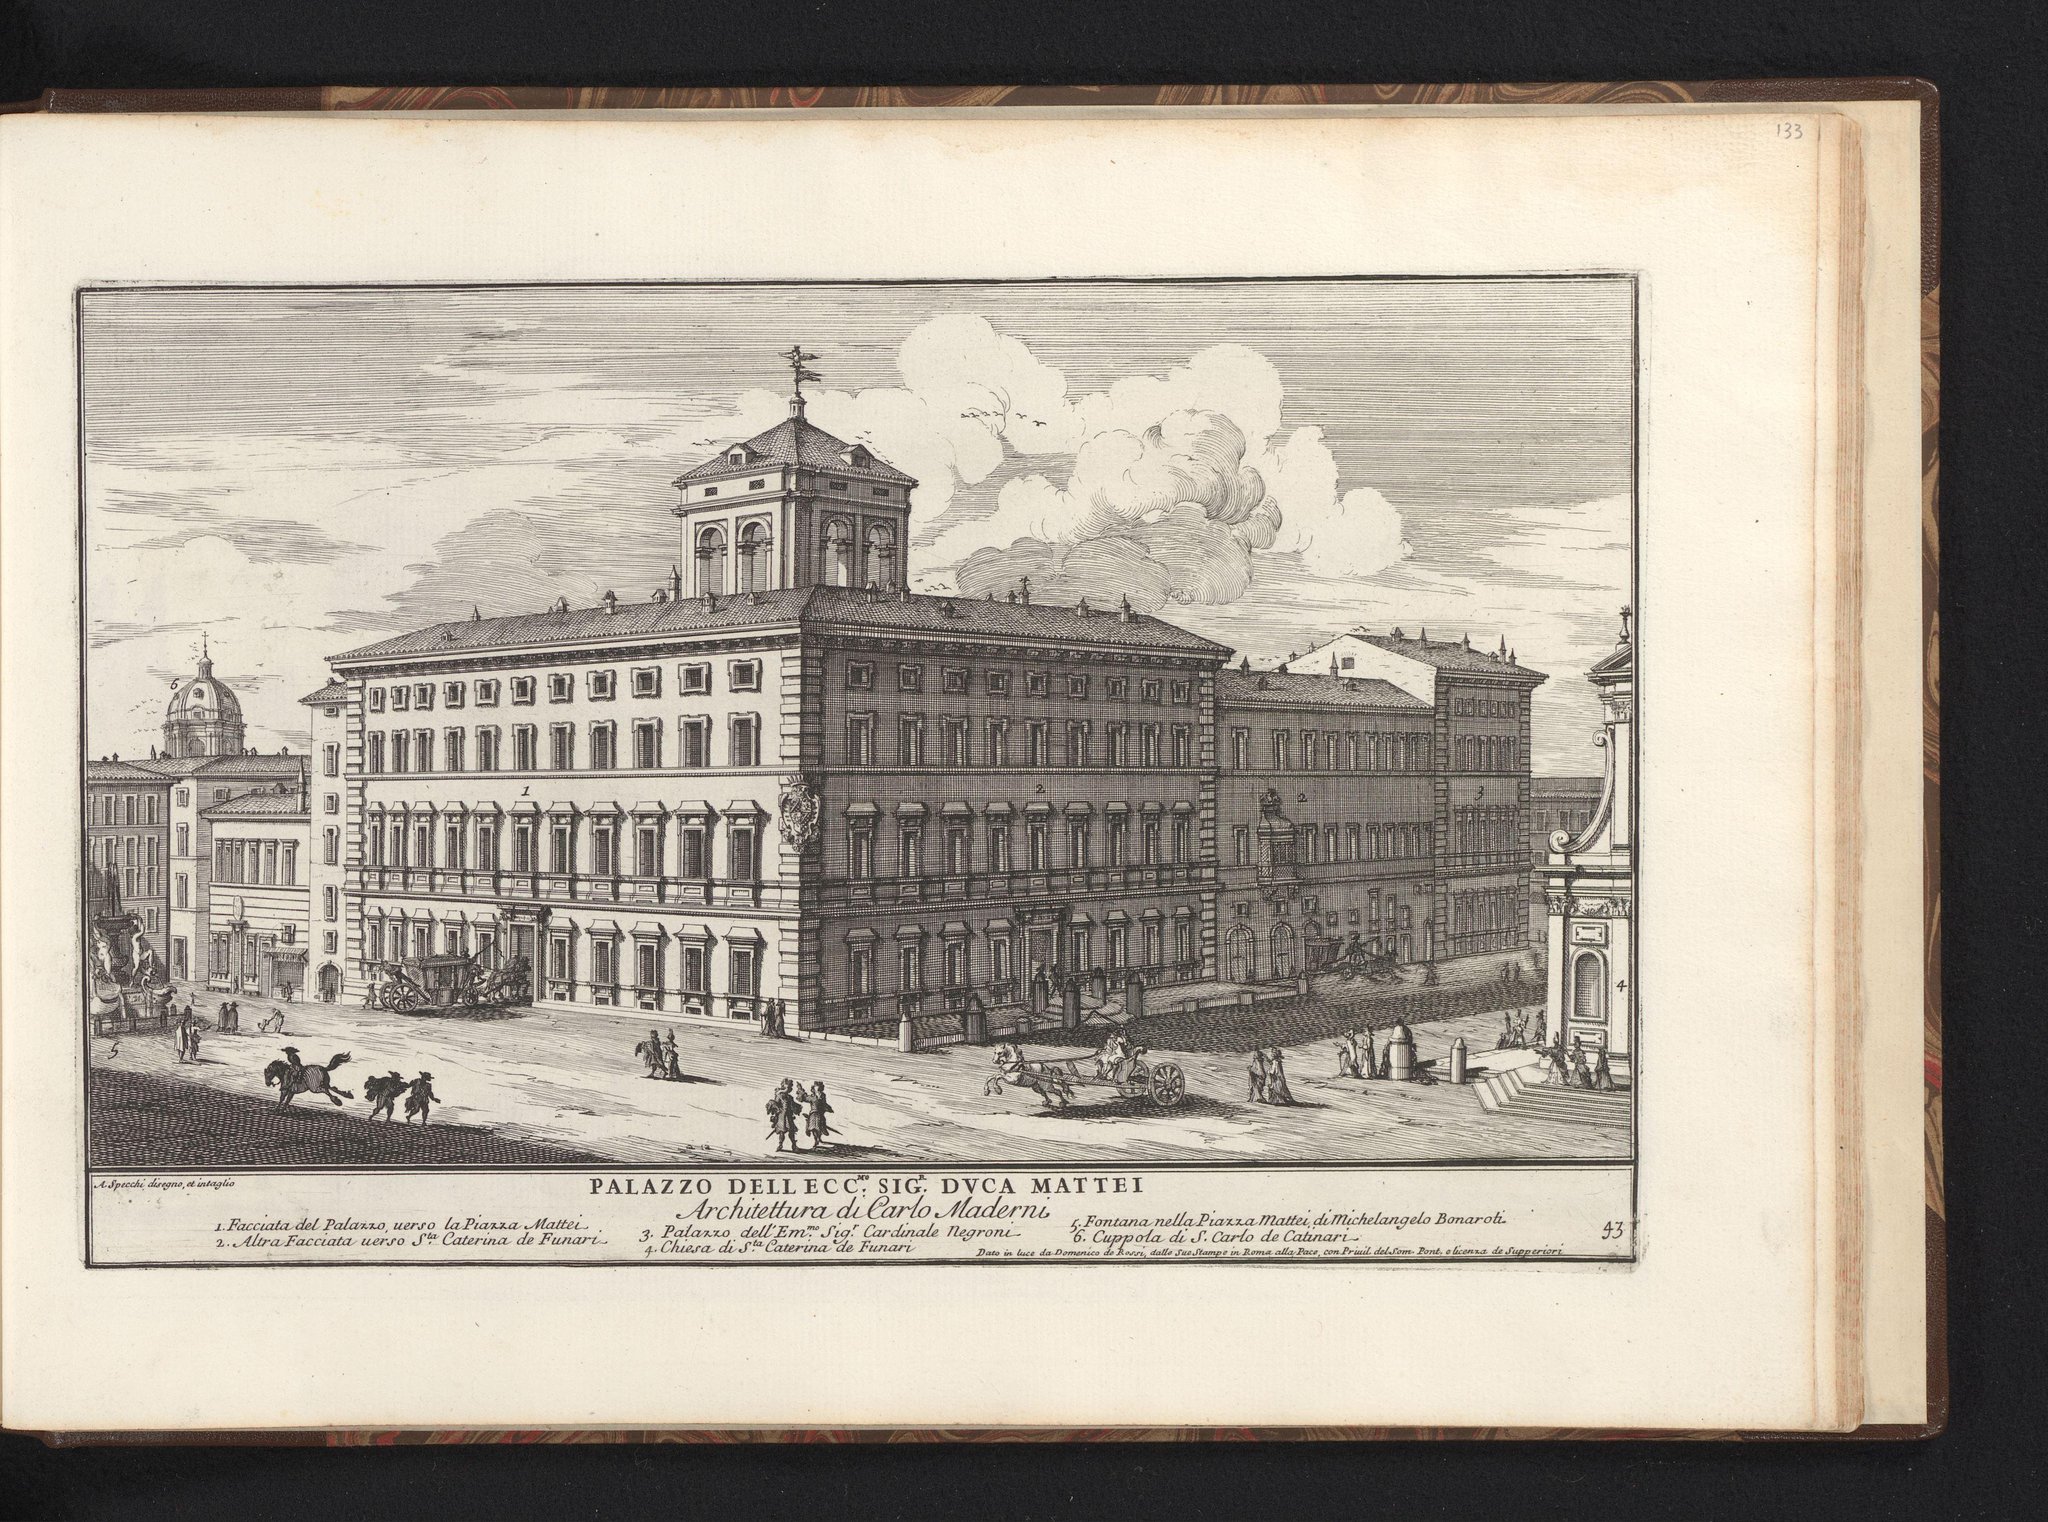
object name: album leaf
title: Moderne gebouwen te Rome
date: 1699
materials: paper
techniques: etching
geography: italy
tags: city-view, and landscape with man-made constructions, hôtel, i.e. small palace in city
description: Deze prent maakt deel uit van een reeks van 52 prenten met voorstellingen van paleizen in Rome. Samen met vier andere reeksen vormt het de grote reeks: 'Il nuovo teatro di Roma moderna'.